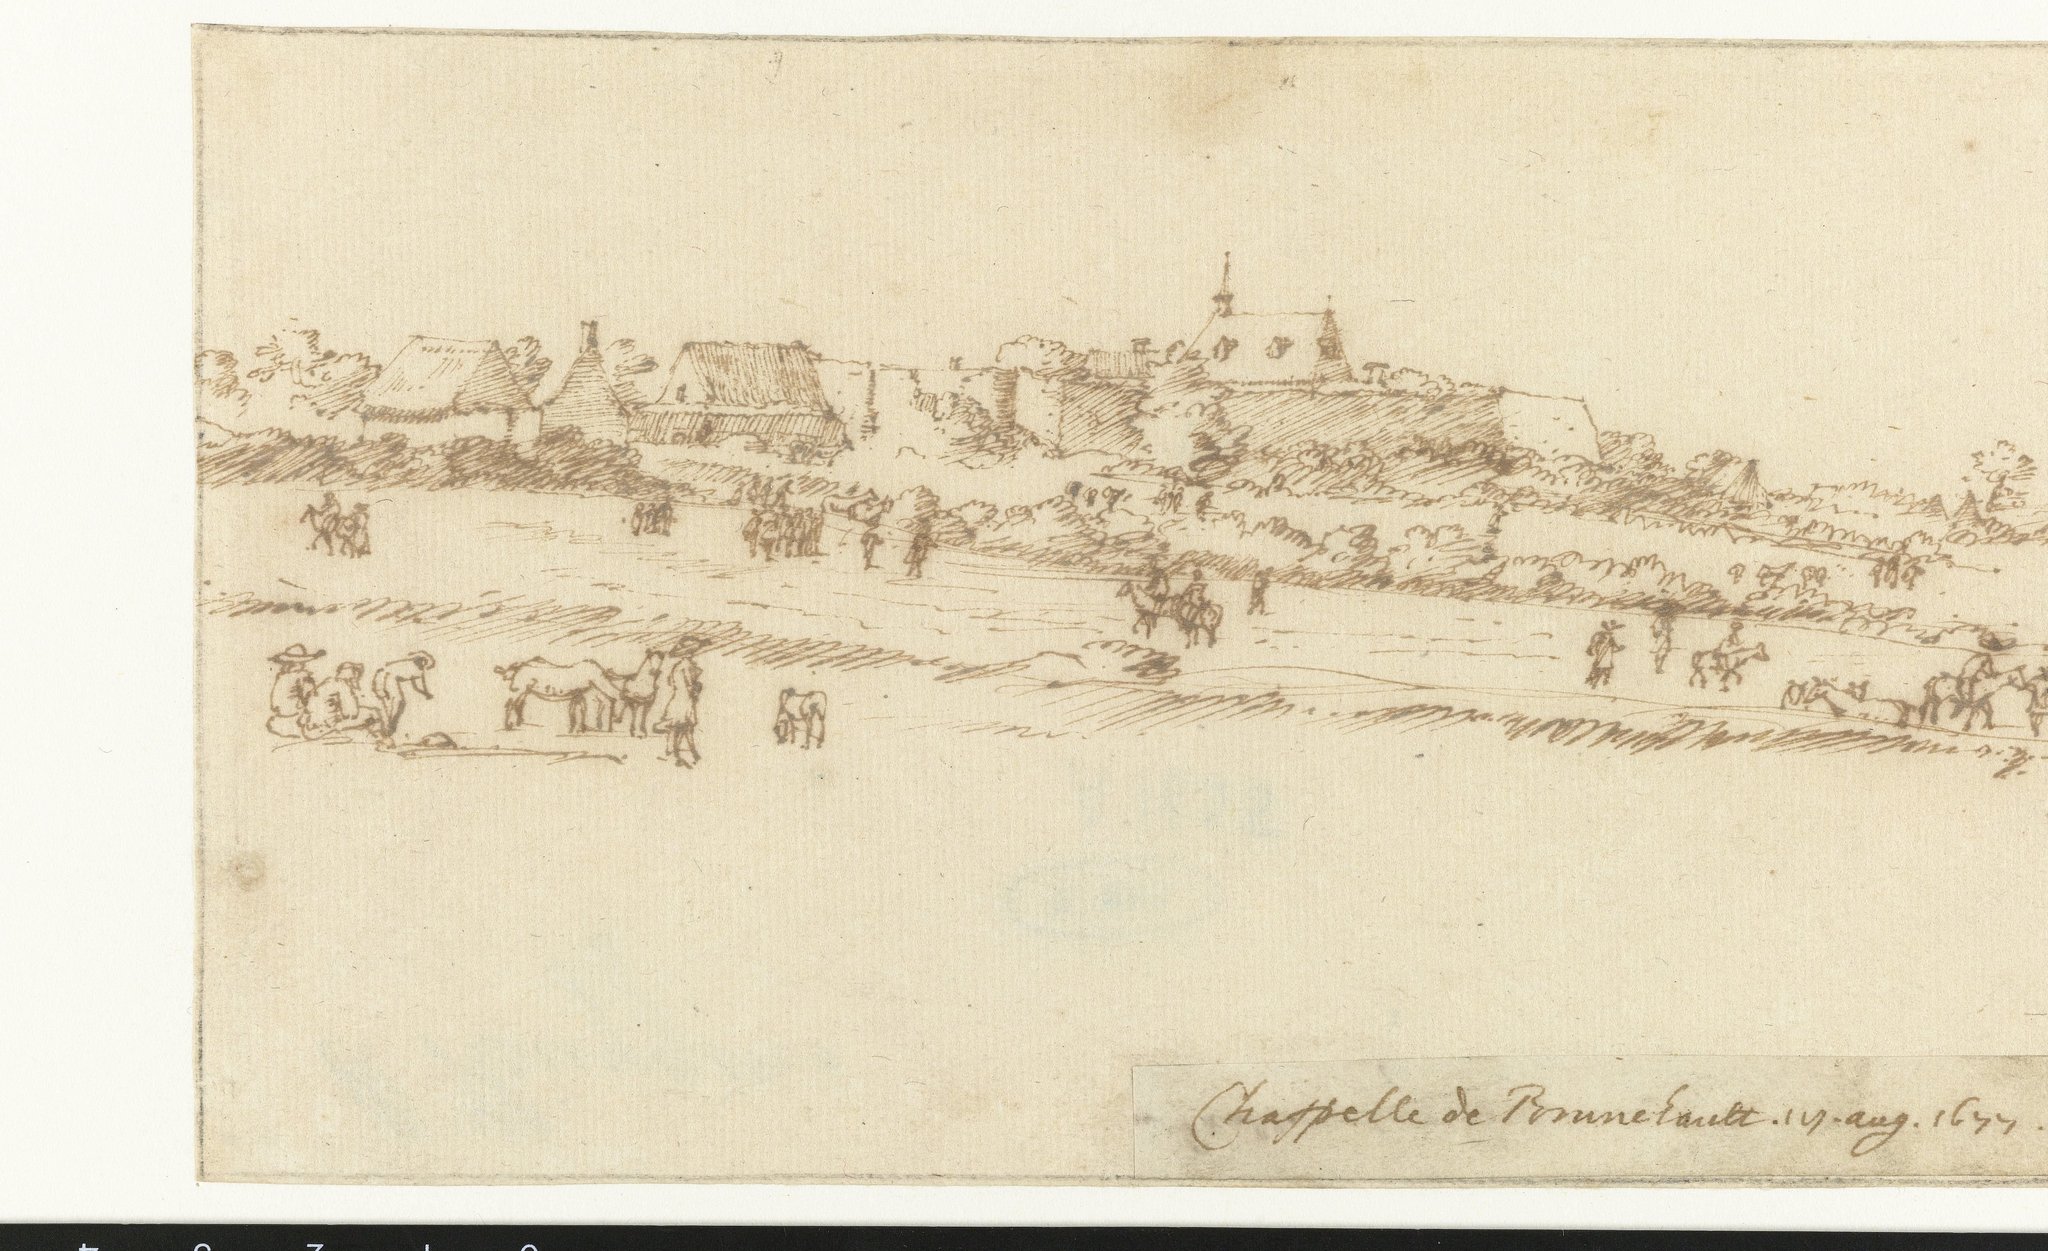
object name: drawing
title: Brunehault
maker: constantijn huygens (ii)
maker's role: draughtsman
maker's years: 1628-1697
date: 1677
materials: ink, paper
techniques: pen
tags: prospect of village, silhouette of village